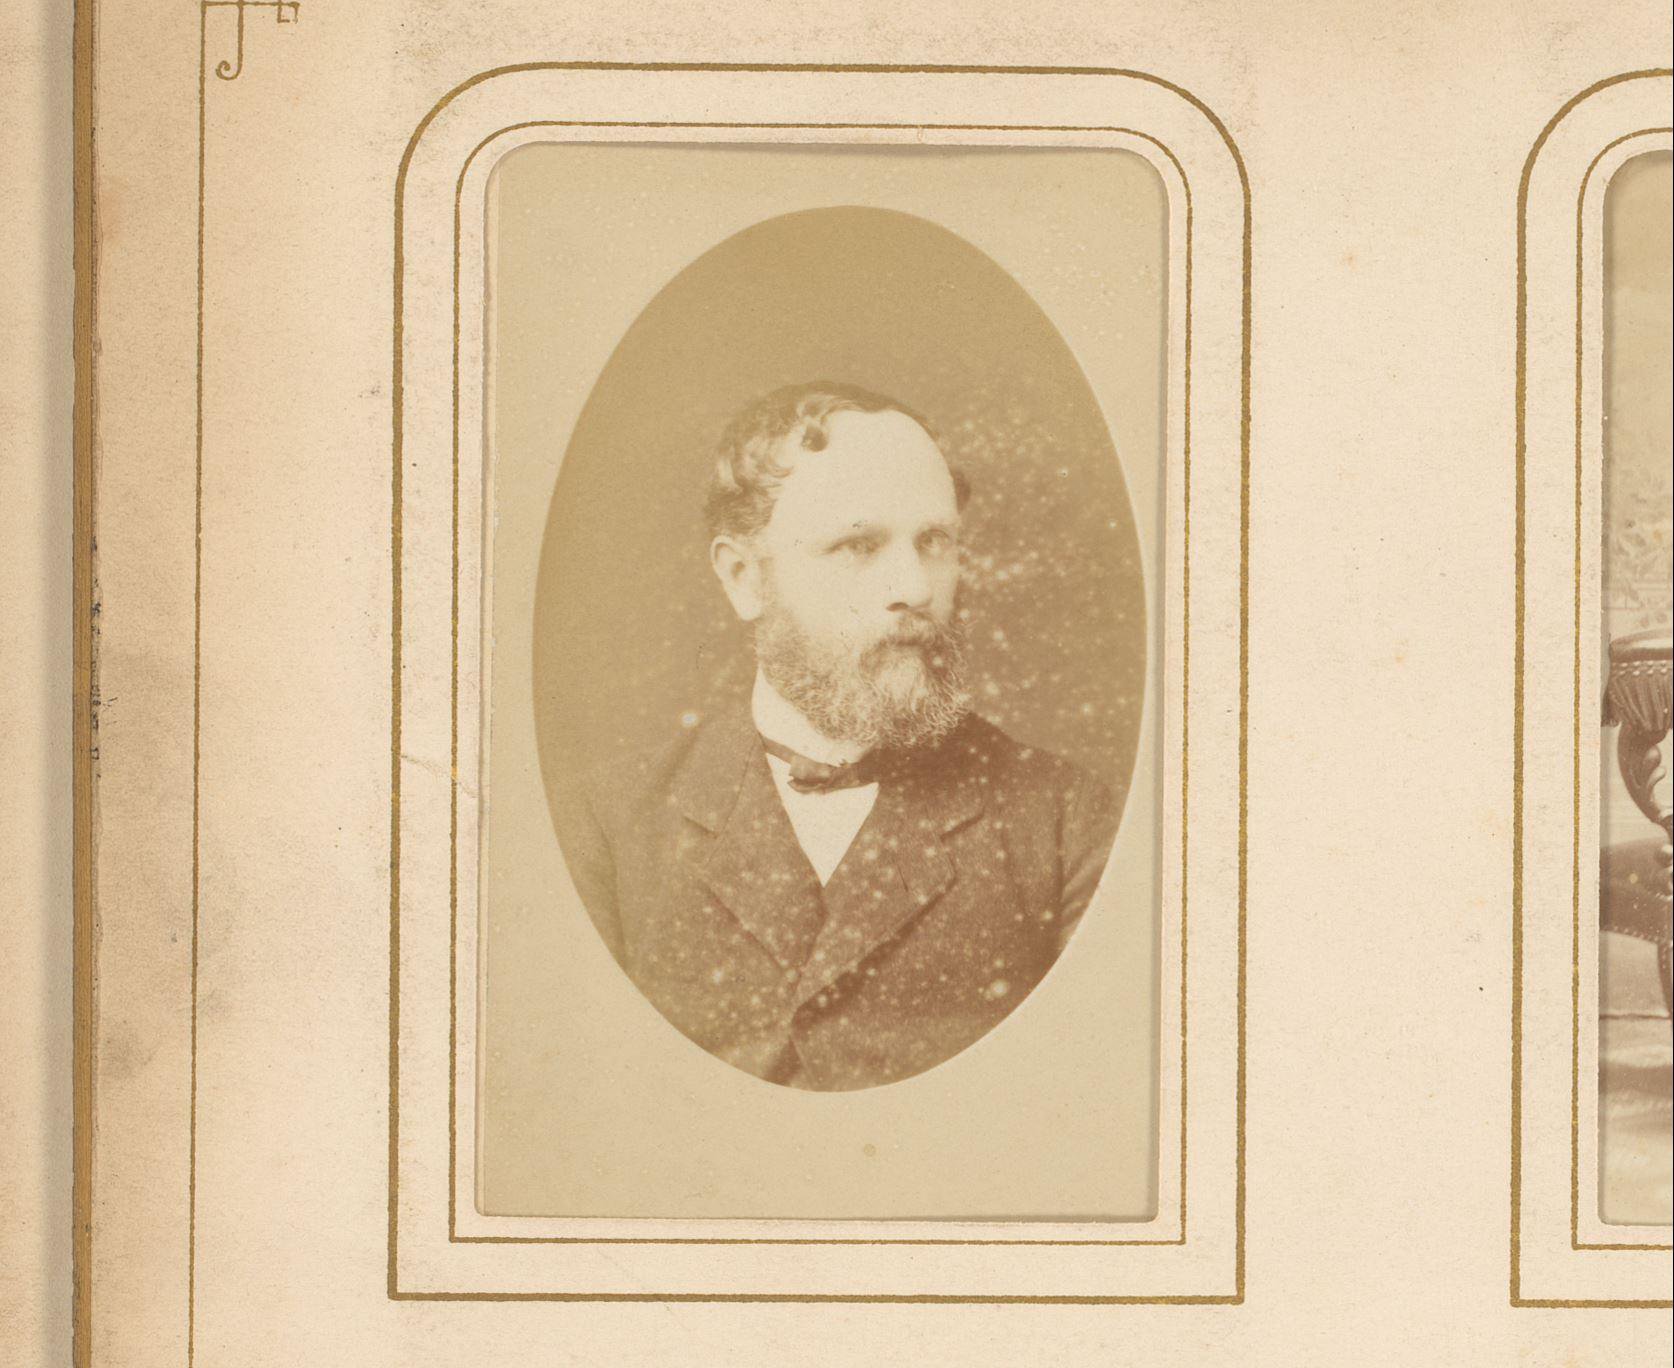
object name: photograph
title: Portret van een man met baard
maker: eugene guérin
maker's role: fotograaf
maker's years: 1845-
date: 1875-1885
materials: cardboard, photographic support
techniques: albumen print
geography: brussels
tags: historical persons, beard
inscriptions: inscription: ‘Eugène Guerin/ Bruxelles 32, Rue de Louvain’